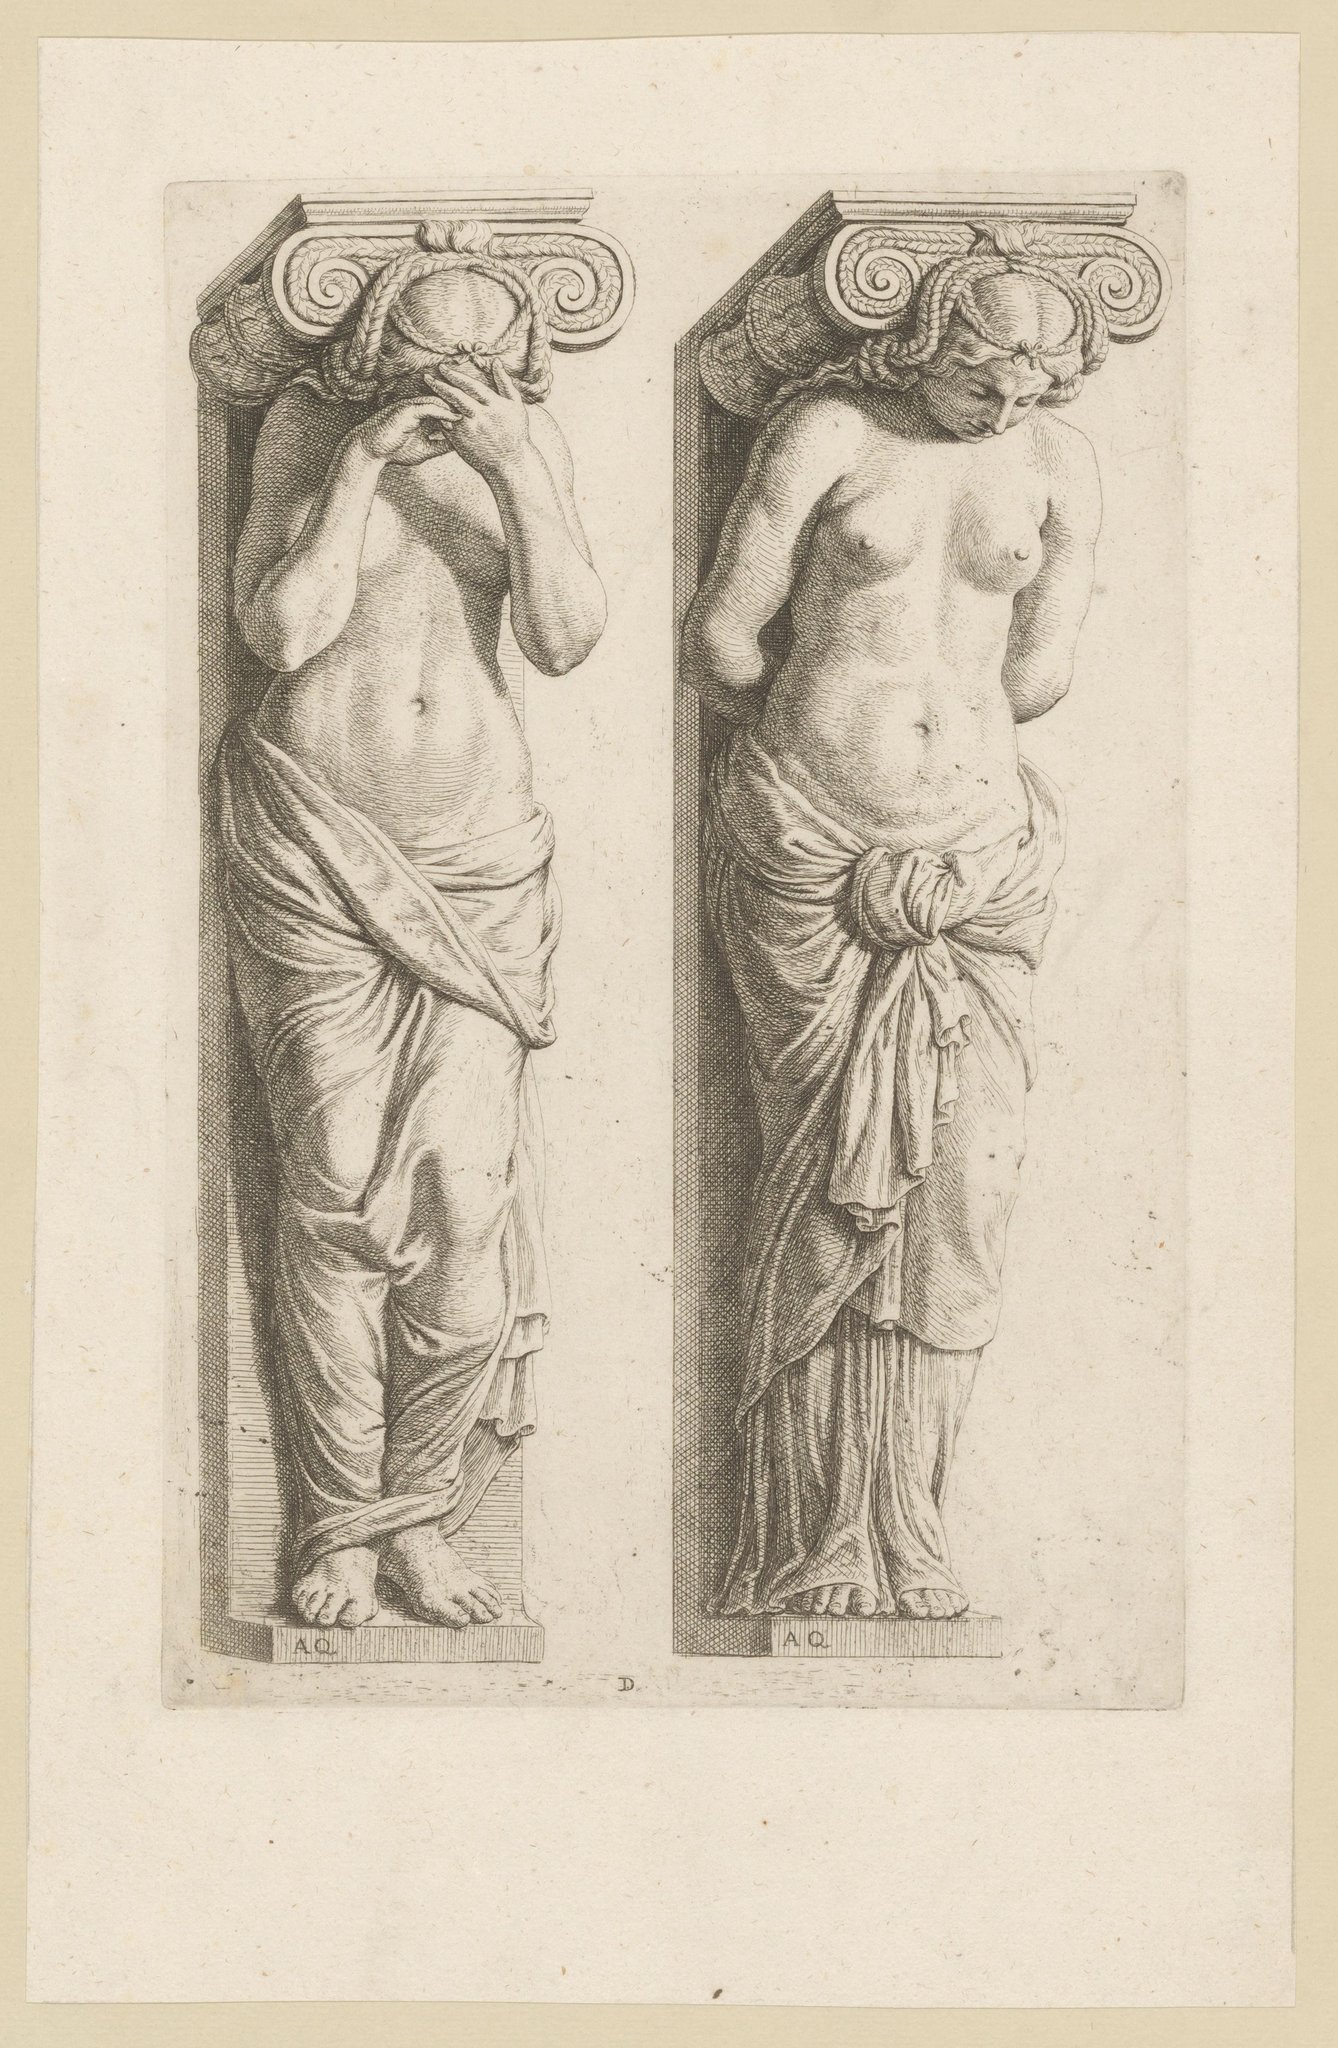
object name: print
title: De twee linker kariatiden uit de Vierschaar van het Stadhuis op de Dam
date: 1655-1665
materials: paper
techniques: engraving, etching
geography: amsterdam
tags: caryatids ~ architecture, townhall, court-room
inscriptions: collector's mark: ‘16,47’ Lugt 1641b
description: Prent gebruikt in: Prima pars. Praecipuarum effigierum ac ornamentorum, amplissimae Curiae Amstelrodamensis (…) / Het eerste deel. Van de voornaemste Statuen ende Ciraten, vant konstijck Stadhuys van Amstelredam, tmeeste in marmer gemaeckt, door Artus Quellinus, Beelthouwer der voorseyde Stadt / La Premier Partie. De plusieurs Figures et ornements, de la Maison de Ville d'Amsterdam (…). Amsterdam: Artus Quellinus (I), 1655. Zie RP-P-AO-22-1-1 voor bijhorende titelpagina. Zie RP-P-AO-22-1-2 voor bijhorend register. Zie RP-P-AO-22-1A, RP-P-AO-22-1B, RP-P-AO-22-1C, RP-P-AO-22-1D-2, RP-P-AO-22-1E, RP-P-AO-22-1F, RP-P-AO-22-1G, RP-P-AO-22-1H, RP-P-AO-22-1I, RP-P-AO-22-1K-1, RP-P-AO-22-1K-2, RP-P-AO-22-1K-3, RP-P-AO-22-1K-4, RP-P-AO-22-1K-5, RP-P-AO-22-1L-1, RP-P-AO-22-1L-2, RP-P-AO-22-1M-1, RP-P-AO-22-1M-2, RP-P-AO-22-1N-1, RP-P-AO-22-1N-2, RP-P-AO-22-1N-3, RP-P-AO-22-1N-4, RP-P-AO-22-1N-5, RP-P-AO-22-1O-1, RP-P-AO-22-1O-2, RP-P-AO-22-1O-3, RP-P-AO-22-1O-4, RP-P-AO-22-1P-1, RP-P-AO-22-1P-2, RP-P-AO-22-1P-3, RP-P-AO-22-1P-4, RP-P-AO-22-1Q-1, RP-P-AO-22-1Q-2, RP-P-AO-22-1Q-3, RP-P-AO-22-1Q-4, RP-P-AO-22-1R-1, RP-P-AO-22-1R-2, RP-P-AO-22-1R-3, RP-P-AO-22-1R-4, RP-P-AO-22-1R-5, RP-P-AO-22-1S-1, RP-P-AO-22-1S-2, RP-P-AO-22-1S-3, RP-P-AO-22-1S-4, RP-P-AO-22-1S-5, RP-P-AO-22-1T-1 en RP-P-AO-22-1T-2 voor andere prenten uit deze publicatie. Zelfde staat van prent ook gebruikt in: Prima pars. Praecipuarum effigierum ac ornamentorum, amplissimae Curiae Amstelrodamensis (…) / Het eerste deel. Van de voornaemste Statuen ende Ciraten, vant konstijck Stadhuys van Amstelredam, tmeeste in marmer gemaeckt, door Artus Quellinus, Beelthouwer der voorseyde Stadt / La Premier Partie. De plusieurs Figures et ornements, de la Maison de Ville d'Amsterdam (…). Amsterdam: Frederik de Wit, 1665. Latere staat van prent ook gebruikt in: Architecture peinture et sculpture de la Maison de Ville d'Amsterdam, representee en CIX. figures en taille-douce (…). Amsterdam: David Mortier, 1719. En in: Architecture peinture et sculpture de la Maison de Ville d'Amsterdam, representee en CIX. figures en taille-douce (…). Amsterdam: Gerard Valck, 1719. En in: Bouw schilder en beeldhouwkonst, van het Stadhuis te Amsteldam, vertoont in CIX figuuren (…). Amsterdam: Covens & Mortier & Covens Jr., s.a. (1774-1783). Zie BK-AM-51-24-A-1, BK-AM-51-24-A-2, BK-AM-51-24-B-1 en BK-AM-51-24-B-2 voor modellen van de beelden van de kariatiden.